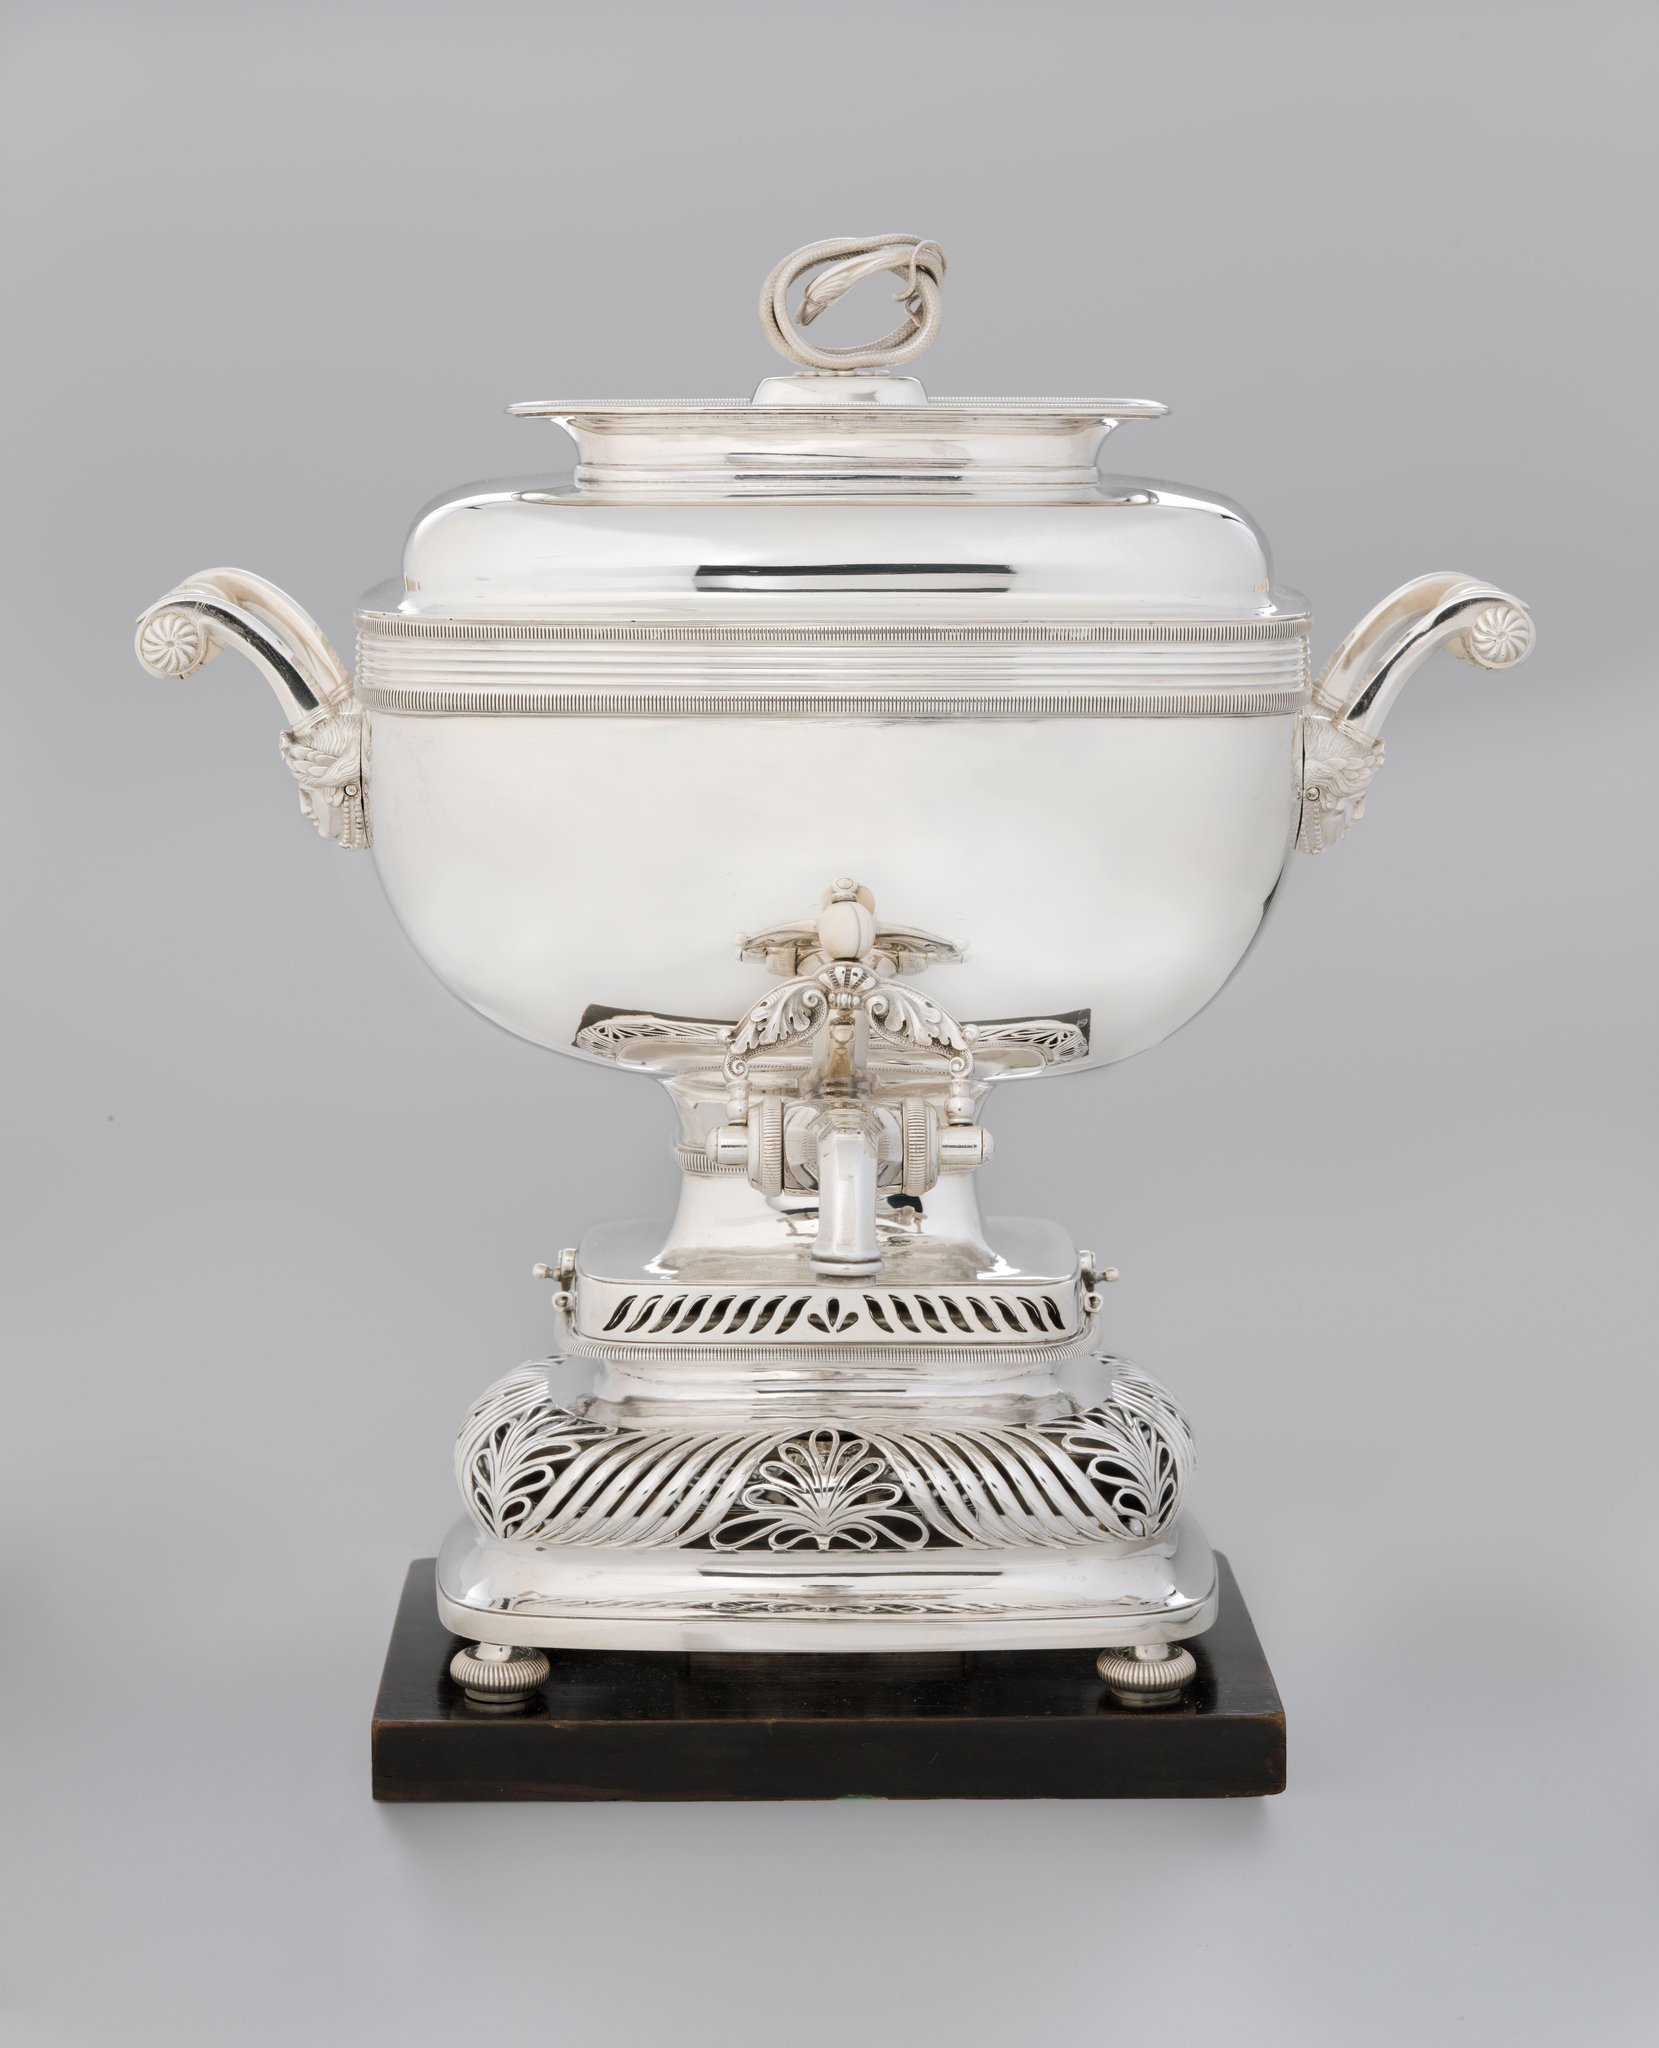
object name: teakettle on stand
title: Tea urn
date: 1828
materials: ivory, silver, wood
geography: amsterdam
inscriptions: assay office mark, assayer's mark, alloy mark, maker's mark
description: Het deksel heeft een gewelfde, zich verjongende wand en een vlakke bovenzijde. De knop heeft de vorm van een opgerolde slang op een rozet.